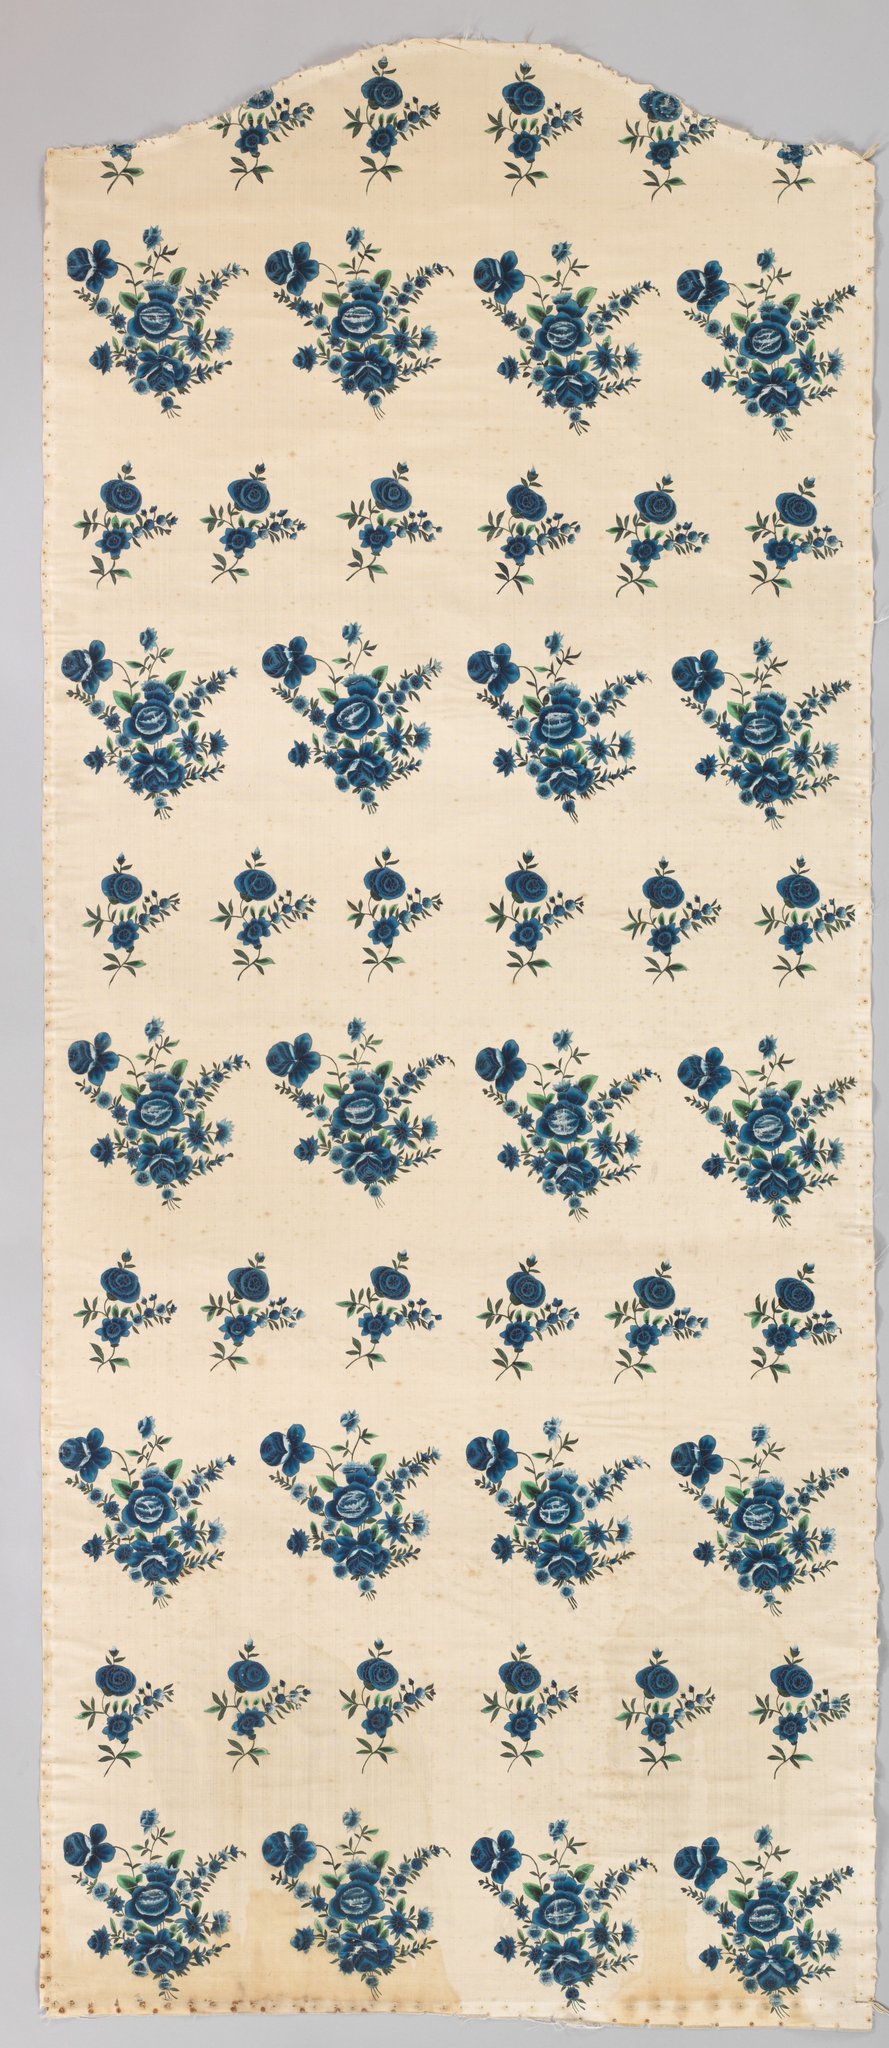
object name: screen panel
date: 1751-1800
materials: silk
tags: flowers